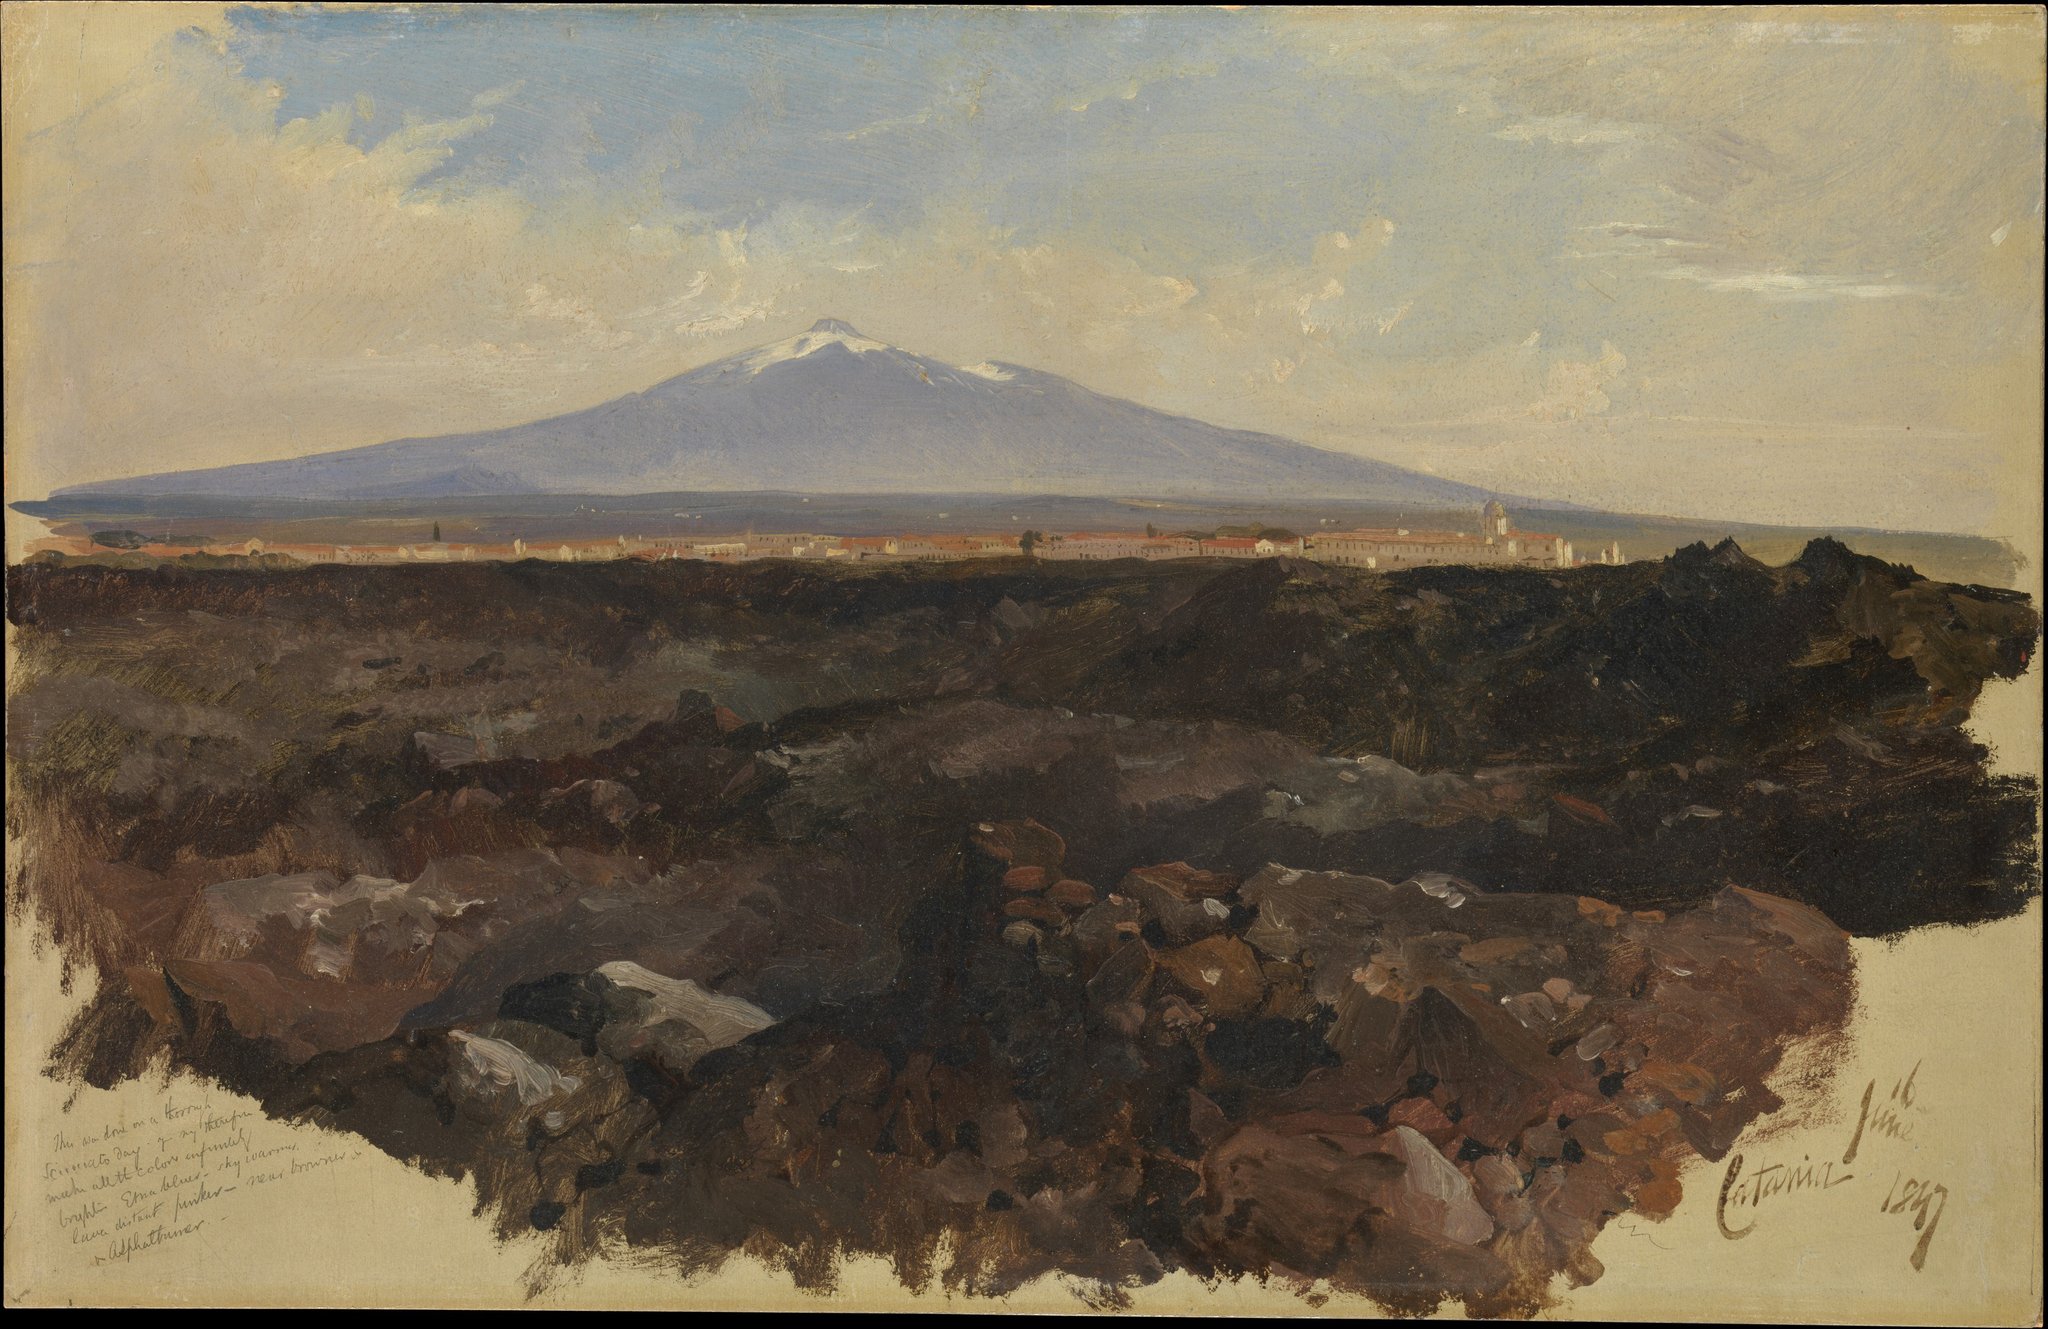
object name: drawing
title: Catania and Mount Etna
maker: edward lear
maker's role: artist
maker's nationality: british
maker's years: 1812-1888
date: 1847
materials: board, oil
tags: mountains,landscapes